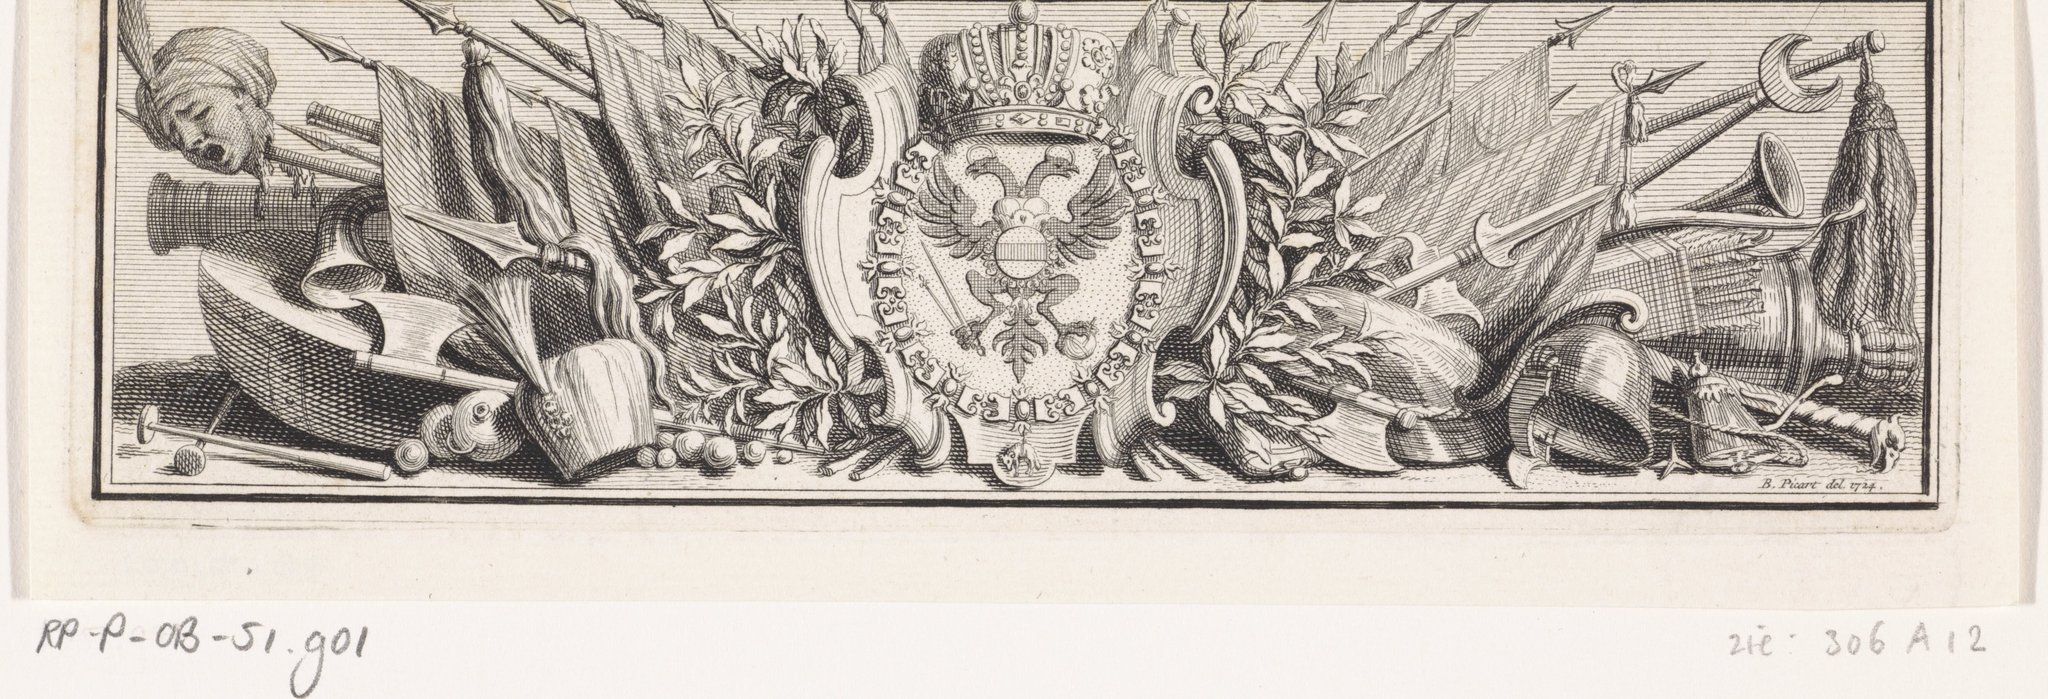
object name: print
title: Wapenschild van keizer Karel VI en wapentuig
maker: bernard picart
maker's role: draughtsman, print maker, publisher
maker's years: 1673-1733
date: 1724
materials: paper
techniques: engraving, etching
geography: amsterdam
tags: vienna, charles vi (holy roman emperor), weapons, knighthood order of the golden fleece - insignia of a knighthood order, e.g.: badge, chain (with name of order), armorial bearing, heraldry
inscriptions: collector's mark: Lugt 240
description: Prent uit: Stosch, Philipp von. Gemmæ antiquæ cælatæ, scalptorum nominibus insignitæ (...). Pierres antiques (...). [Vertaald uit het Latijn door] Henri Philippe de Limiers. Amsterdam: Bernard Picart, 1724.